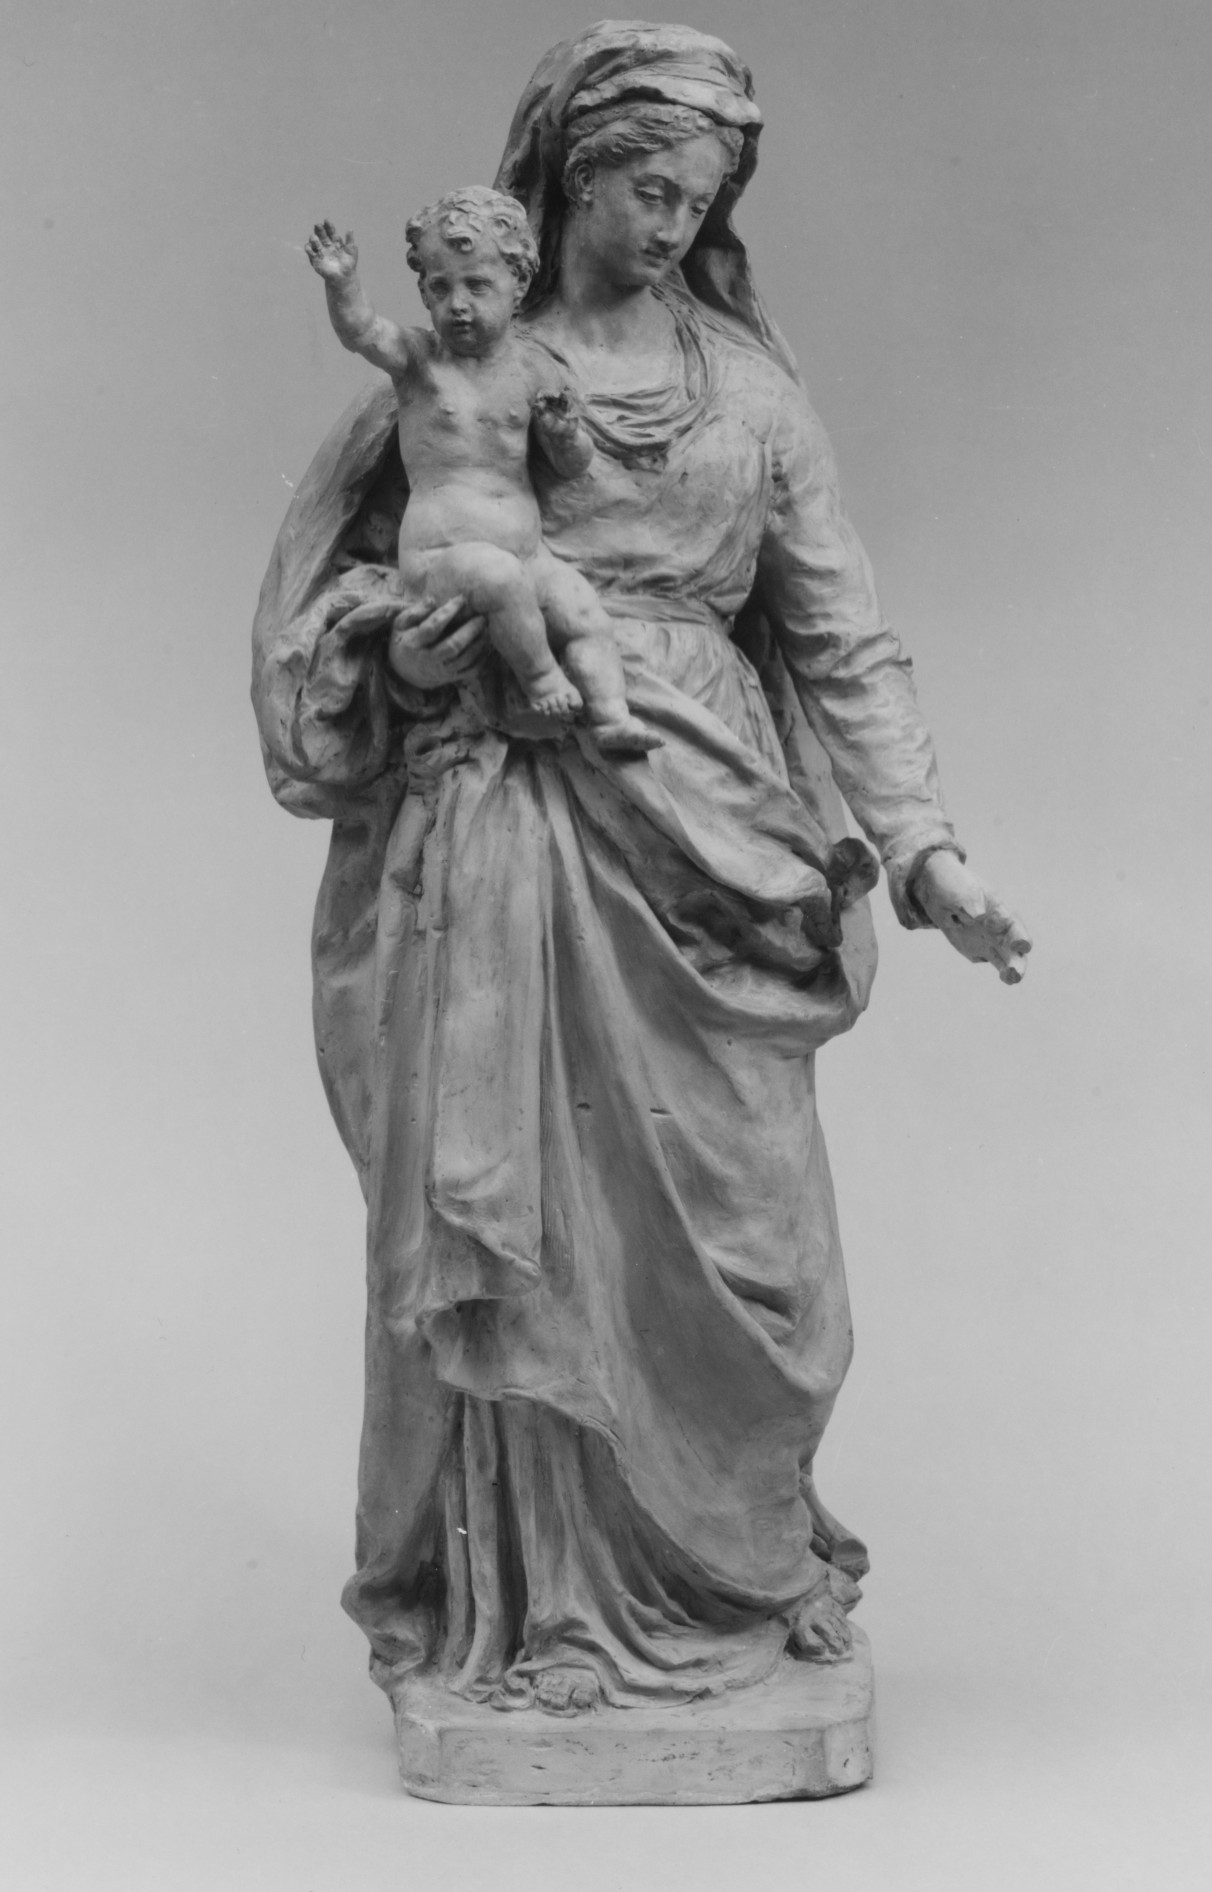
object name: statuette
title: Madonna and Child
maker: giovanni maria morlaiter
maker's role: artist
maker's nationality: italian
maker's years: 1699-1781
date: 1734-1766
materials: terracotta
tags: madonna and child